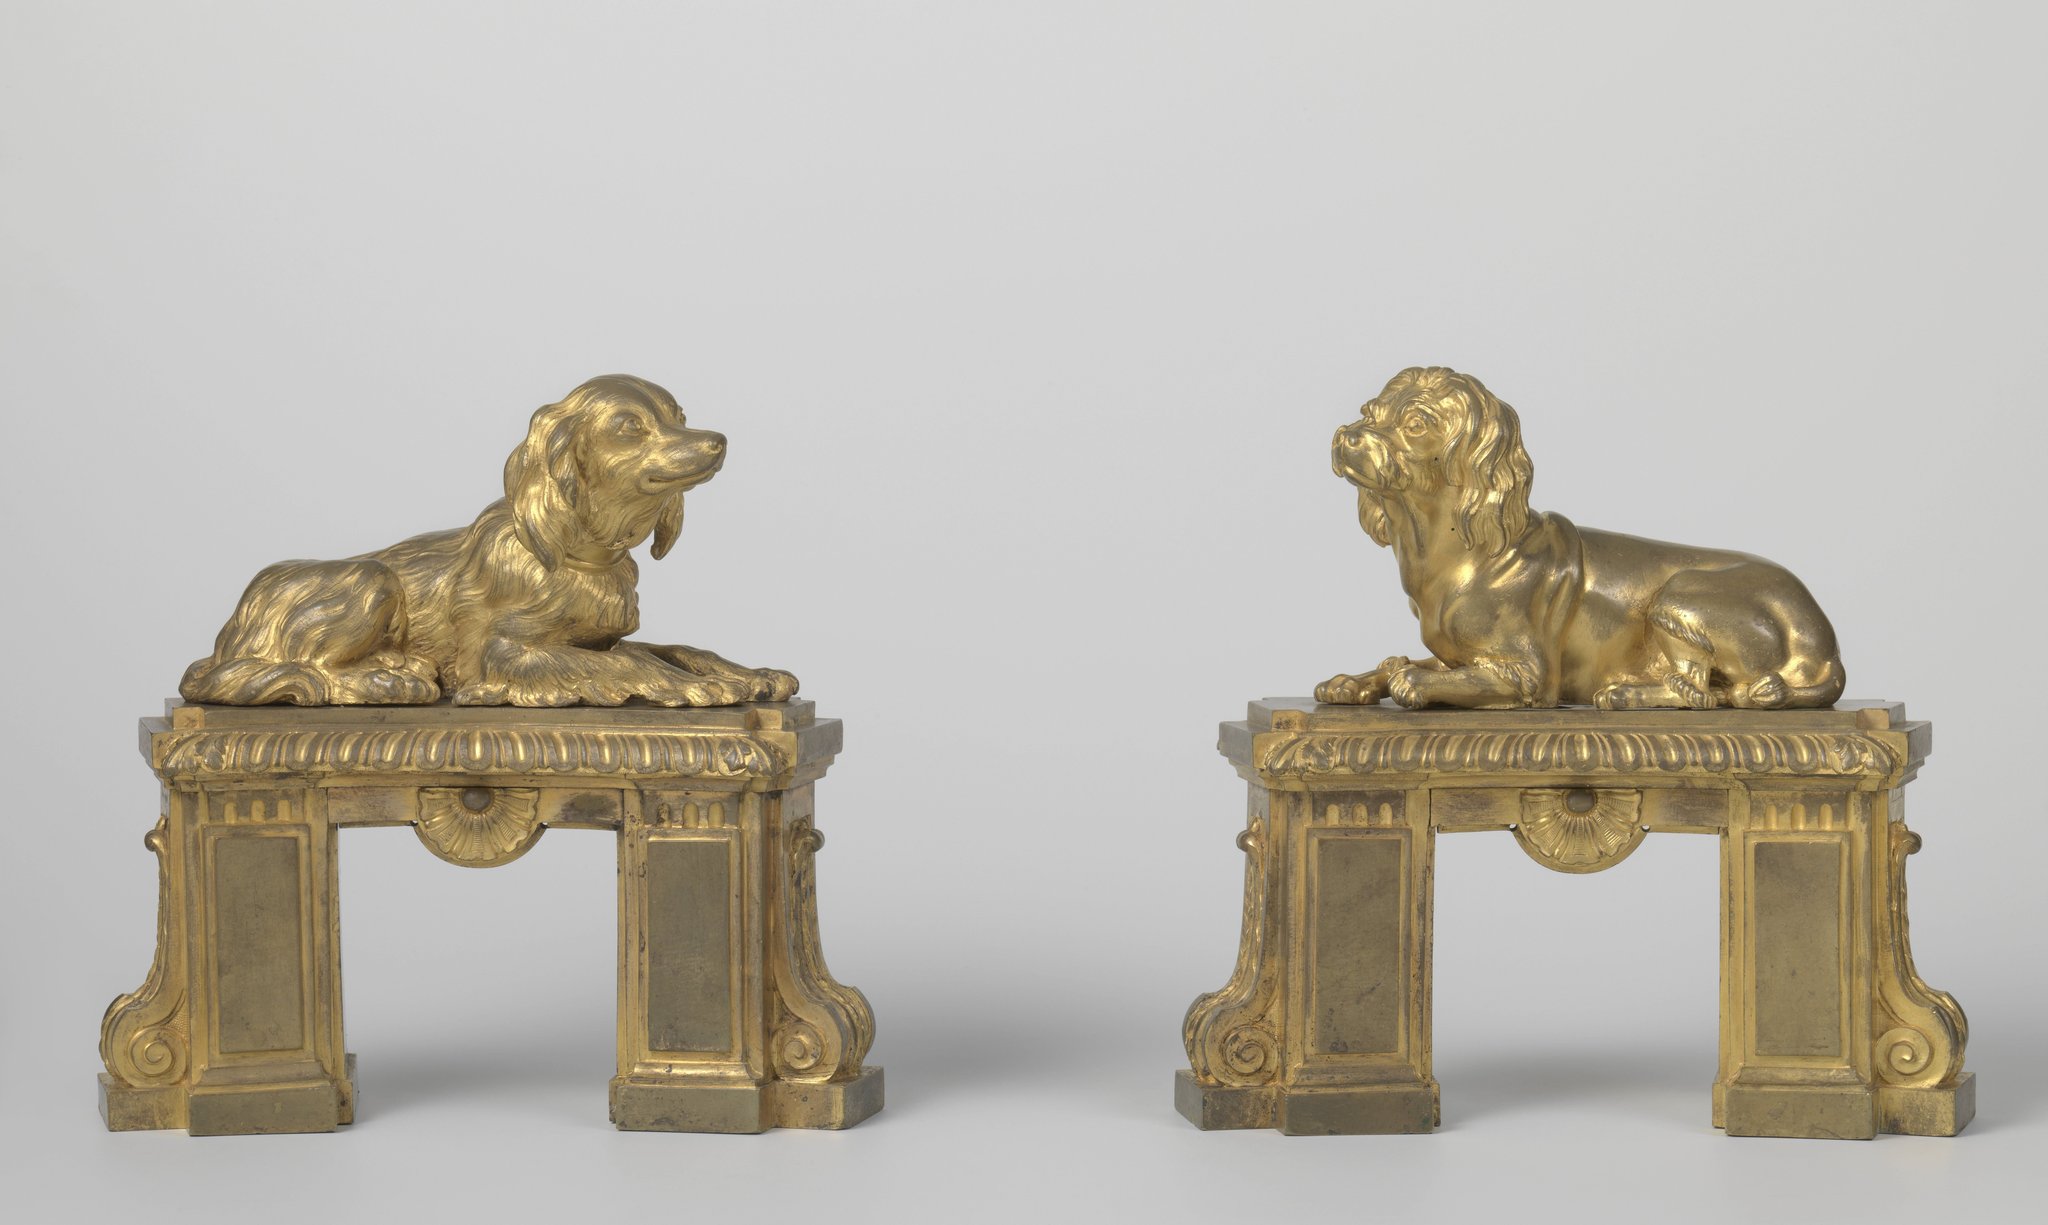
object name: andiron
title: Vuurbok van verguld brons met liggende hond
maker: Anonymous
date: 1775-1800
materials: bronze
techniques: gilding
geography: france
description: Verguld bronzen vuurbok. Op een verhoging op een rechthoekige plaat, rustend op twee rechthoekige steunen, ligt een hond. Het gehele basement is licht gebogen. De steunen worden geflankeerd door versierde consoles en vertonen vlakke velden met guttae. In het midden is een rosetvormig motief aangebracht. De dekplaat vertoont aan de voorkant een eierlijst met een bloemmotief in de hoeken. De dekplaat en verhoging hebben uitgespaarde hoeken.